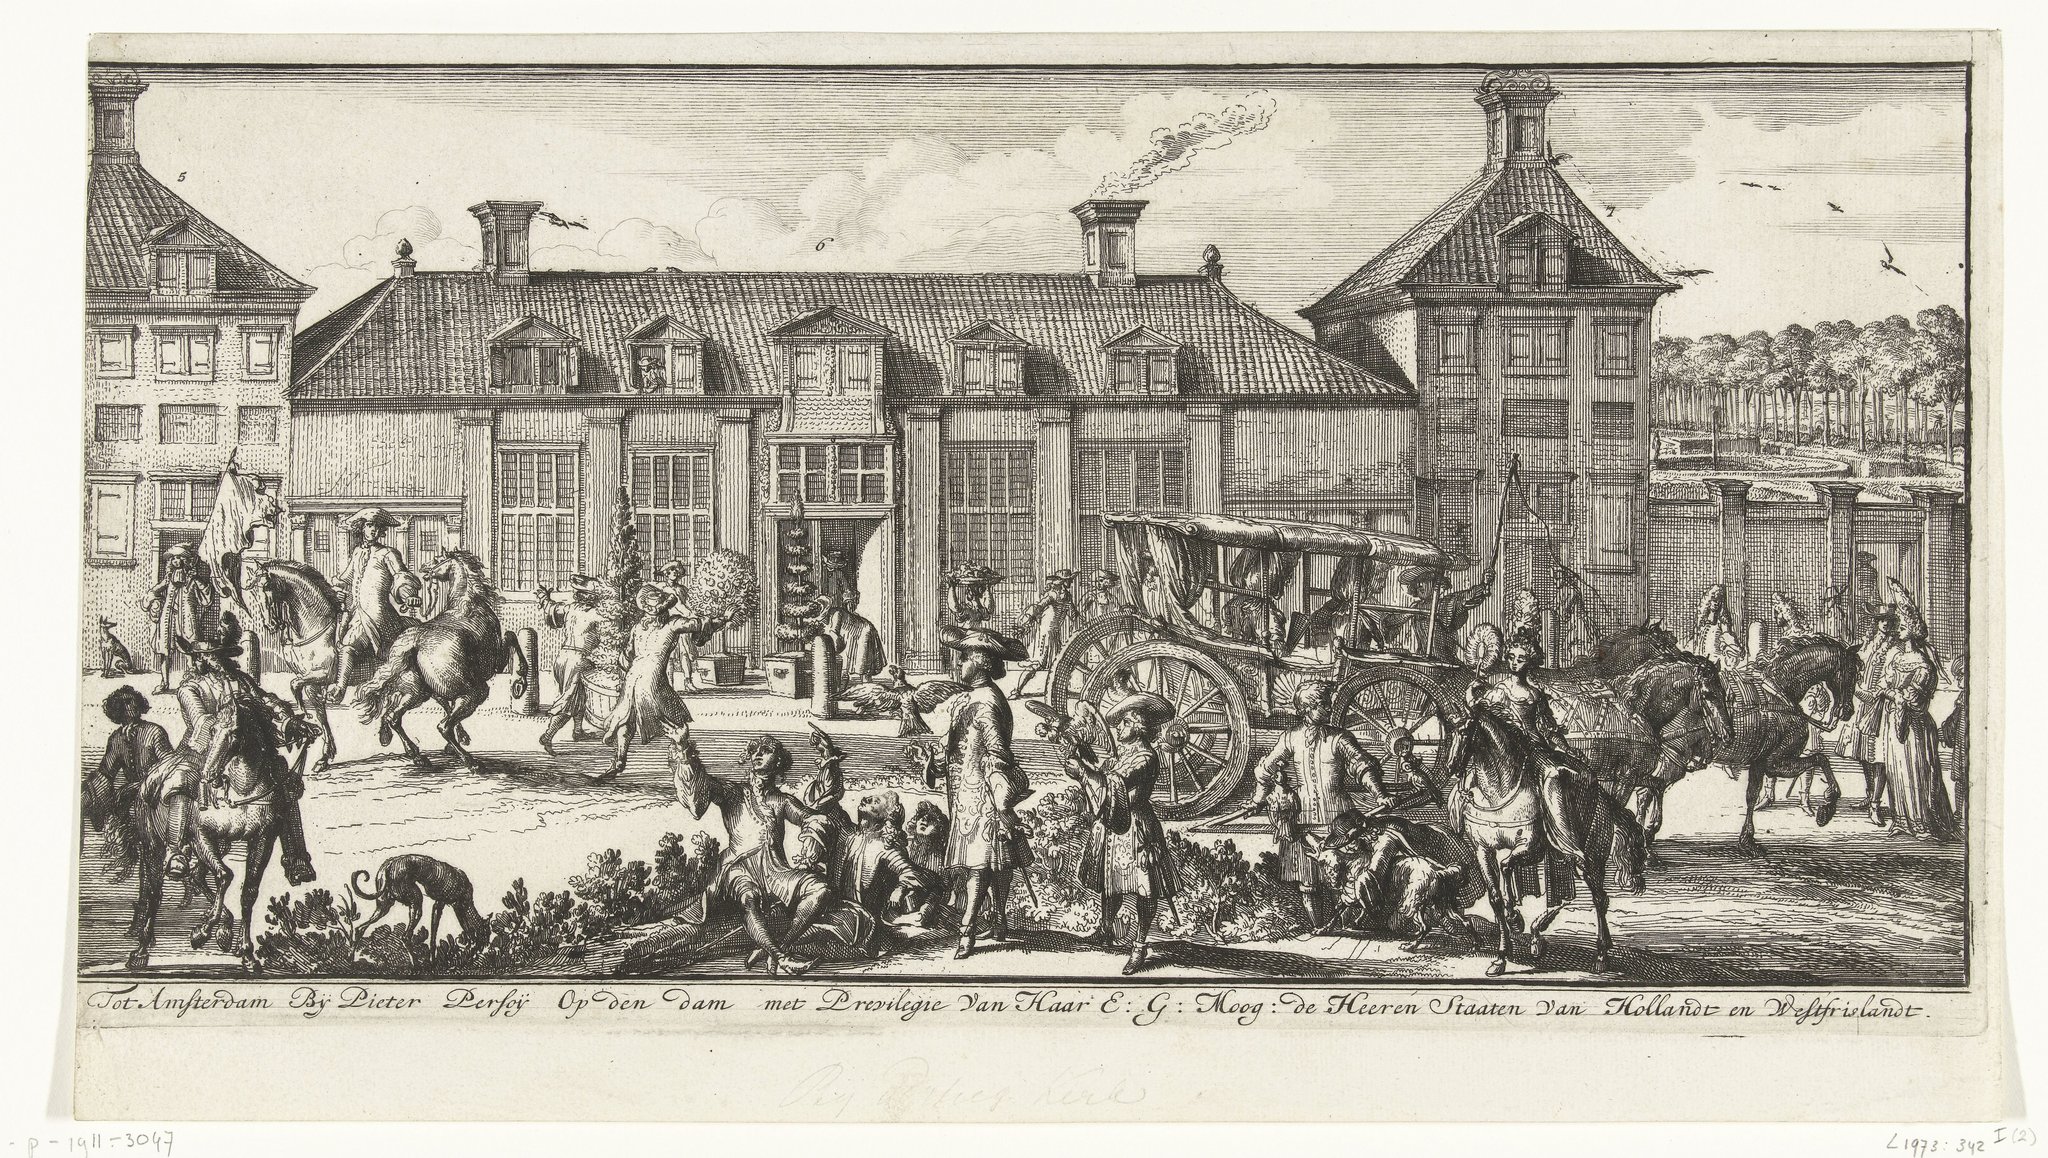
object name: print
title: Gezichten op Paleis Het Loo, de bijbehorende gebouwen en het bijbehorende park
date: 1690-1694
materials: paper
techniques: etching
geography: amsterdam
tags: the hague, william iii (prince of orange and king of england, scotland, and ireland), sports, games ~ animals (+ hunting with falcon, hawk; falconry), four-wheeled, animal-drawn vehicle, e.g.: cab, carriage, coach, palace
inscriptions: collector's mark: Lugt 2228a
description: Gezicht op het rechterdeel van Paleis Het Loo, met valkeniers, ruiters, een koets en voornaam geklede mannen en vrouwen ervoor. Dit blad maakt deel uit van een omvangrijke prent met een gezicht op Paleis Het Loo, omgeven door dertien gezichten op de bijbehorende gebouwen en het bijbehorende park (boven, links, rechts), en een profiel van het paleis (onder).